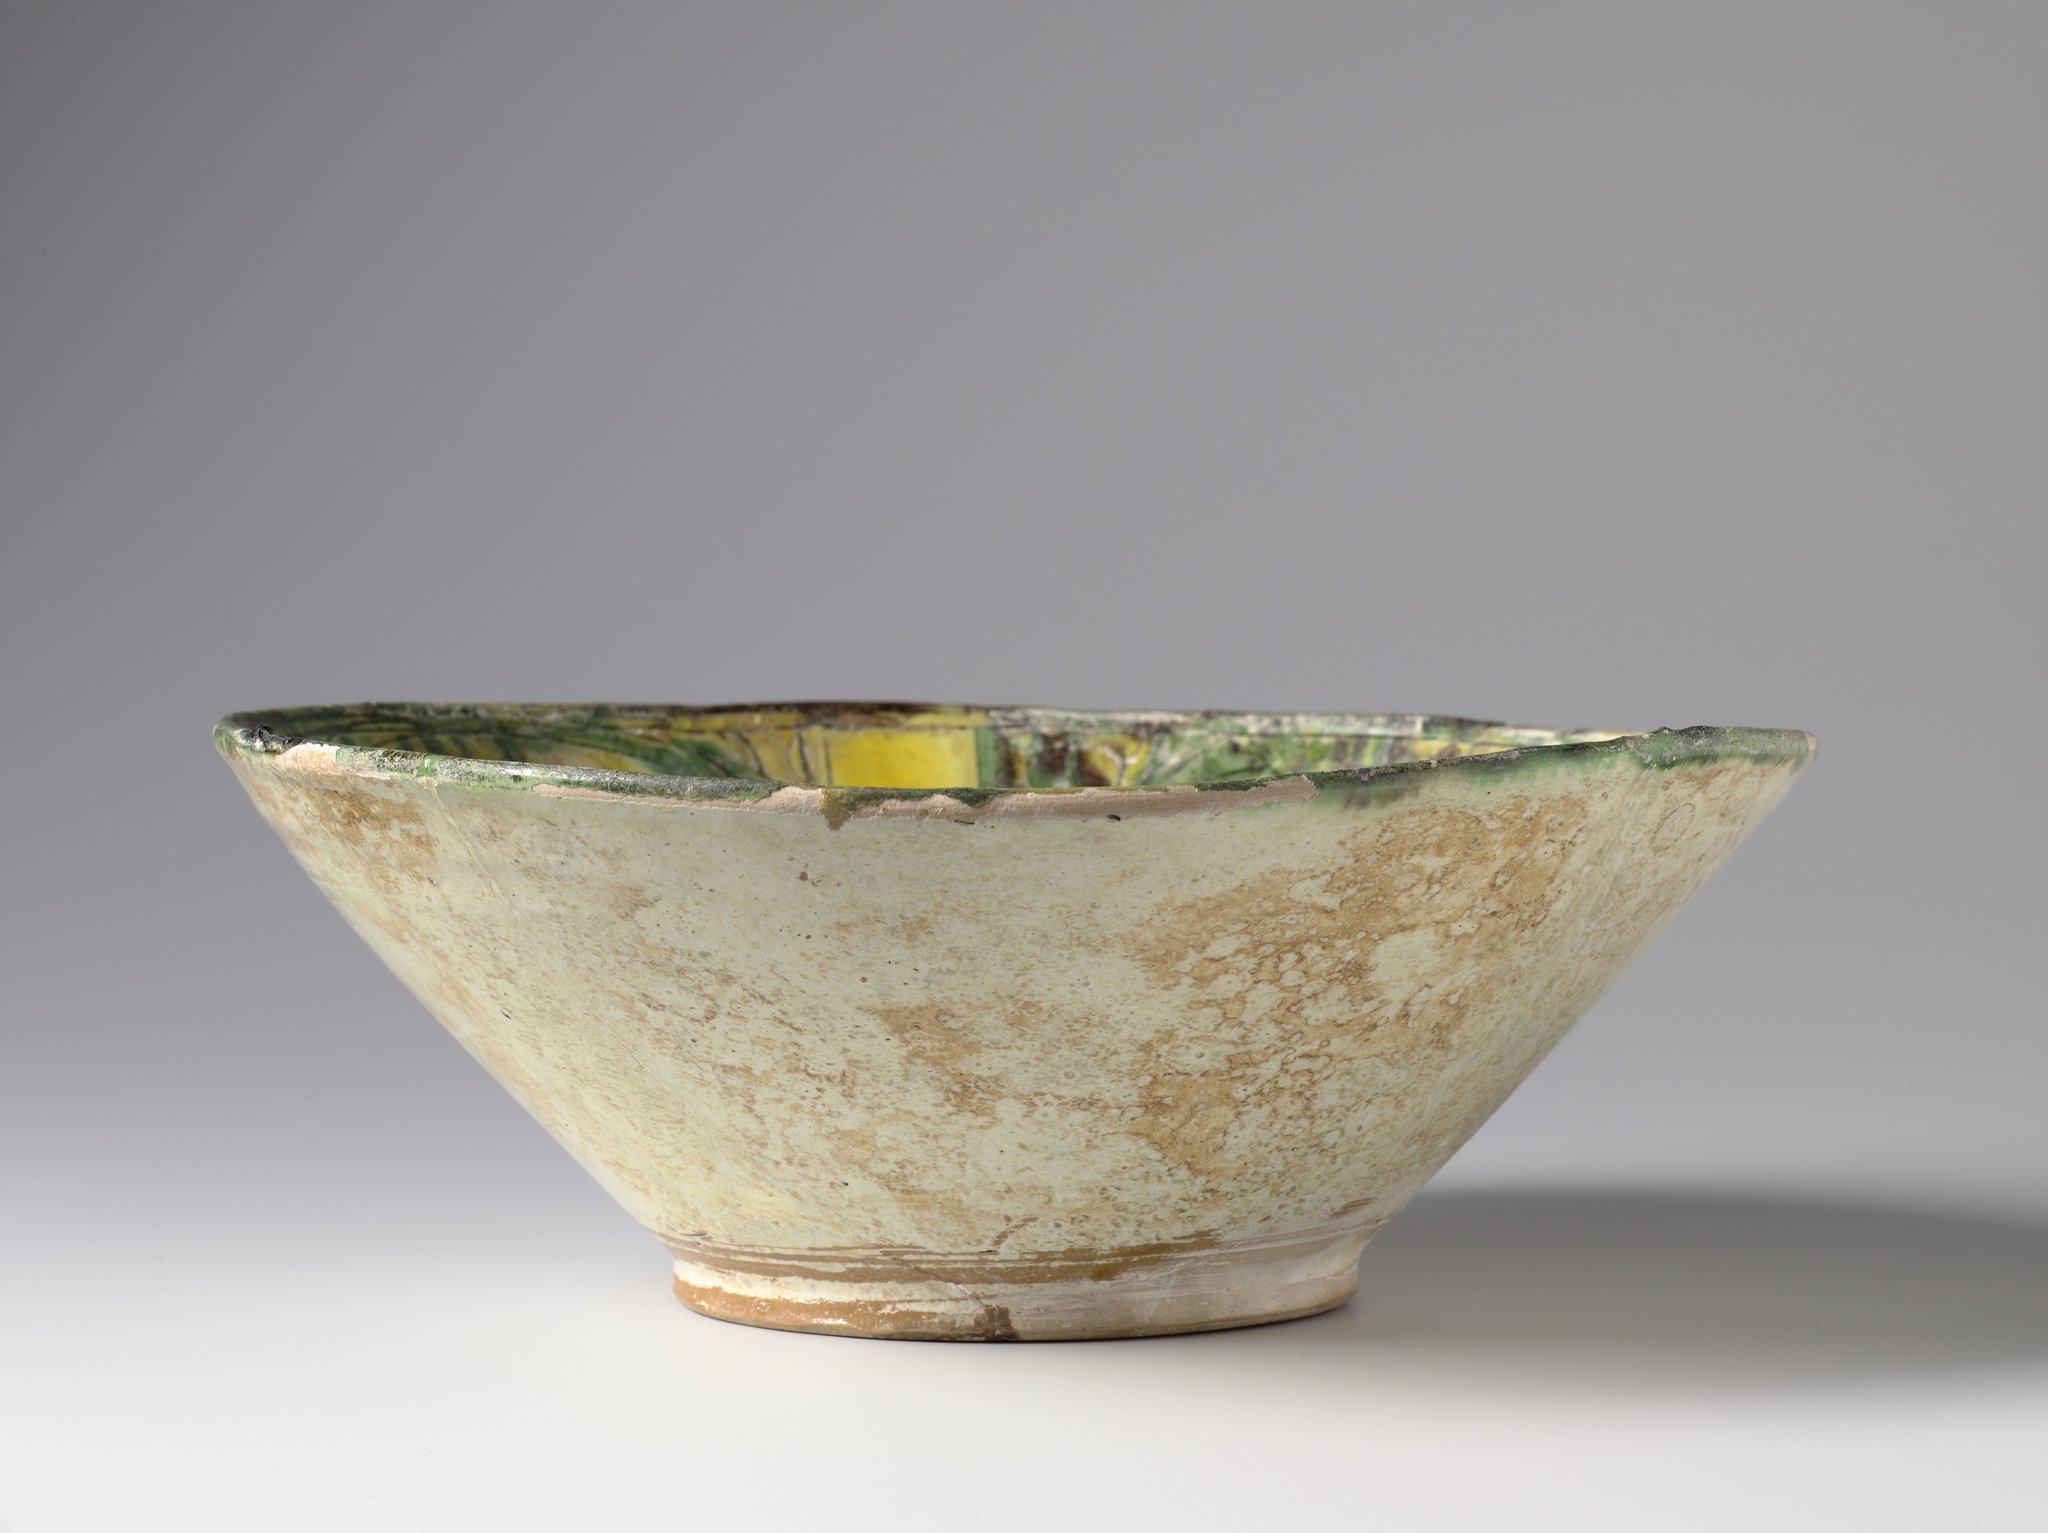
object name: bowl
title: Bowl decorated in green, yellow and manganese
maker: Anonymous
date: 900-999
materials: earthenware, glaze, paint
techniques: firing, turning, vitrification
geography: iran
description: Kom van aardewerk gedecoreerd met sgraffito en polychrome versiering van gele en groene spatten loodglazuur en mangaanbruine slib op engobe van witte slib.